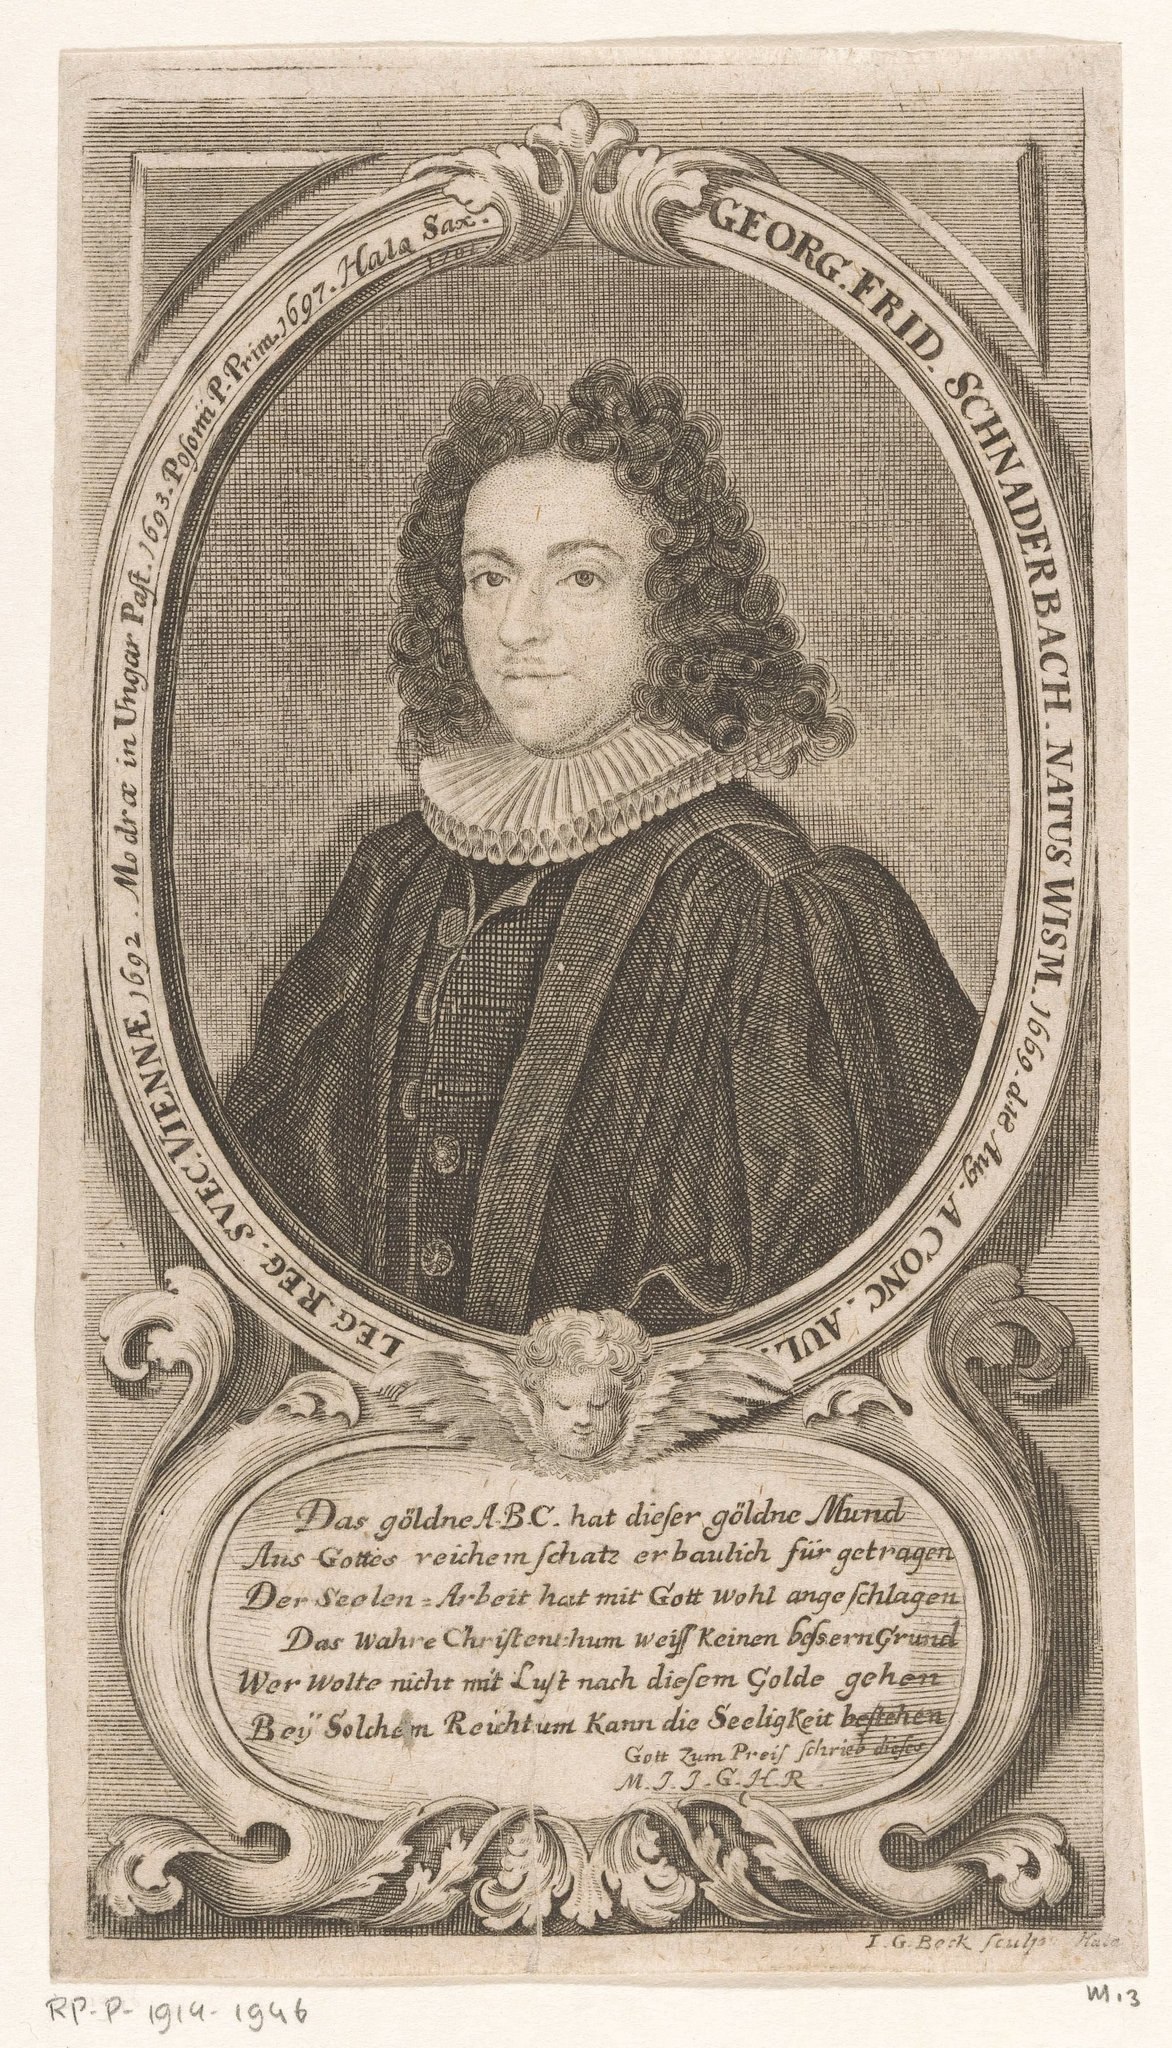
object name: print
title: Portret van Georg Friedrich Schnaderbach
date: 1701-1707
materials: paper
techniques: engraving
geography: halle an der saale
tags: berlin, historical persons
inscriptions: collector's mark: Lugt 2228